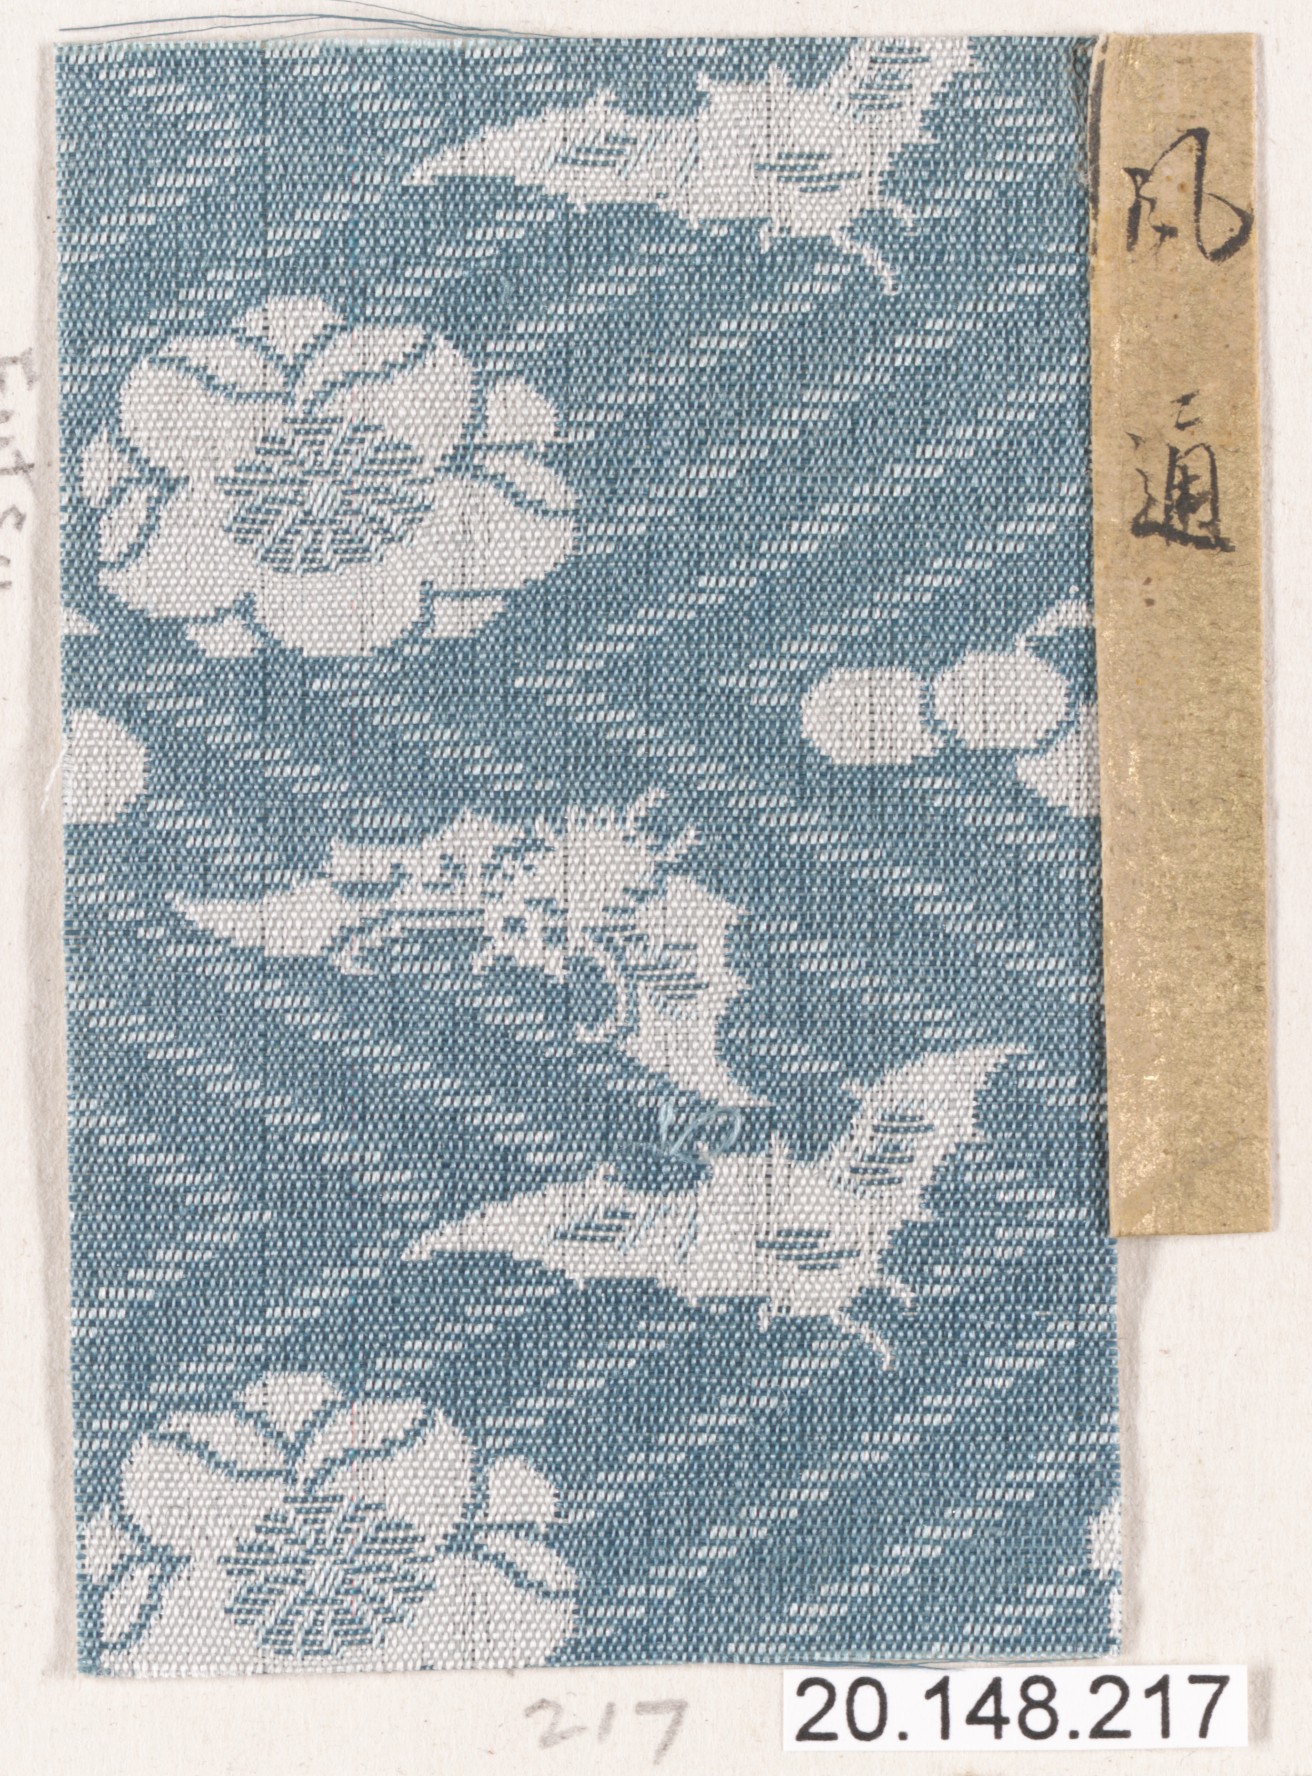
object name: piece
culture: japanese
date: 1701-1800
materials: silk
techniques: compound weave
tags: bats,flowers